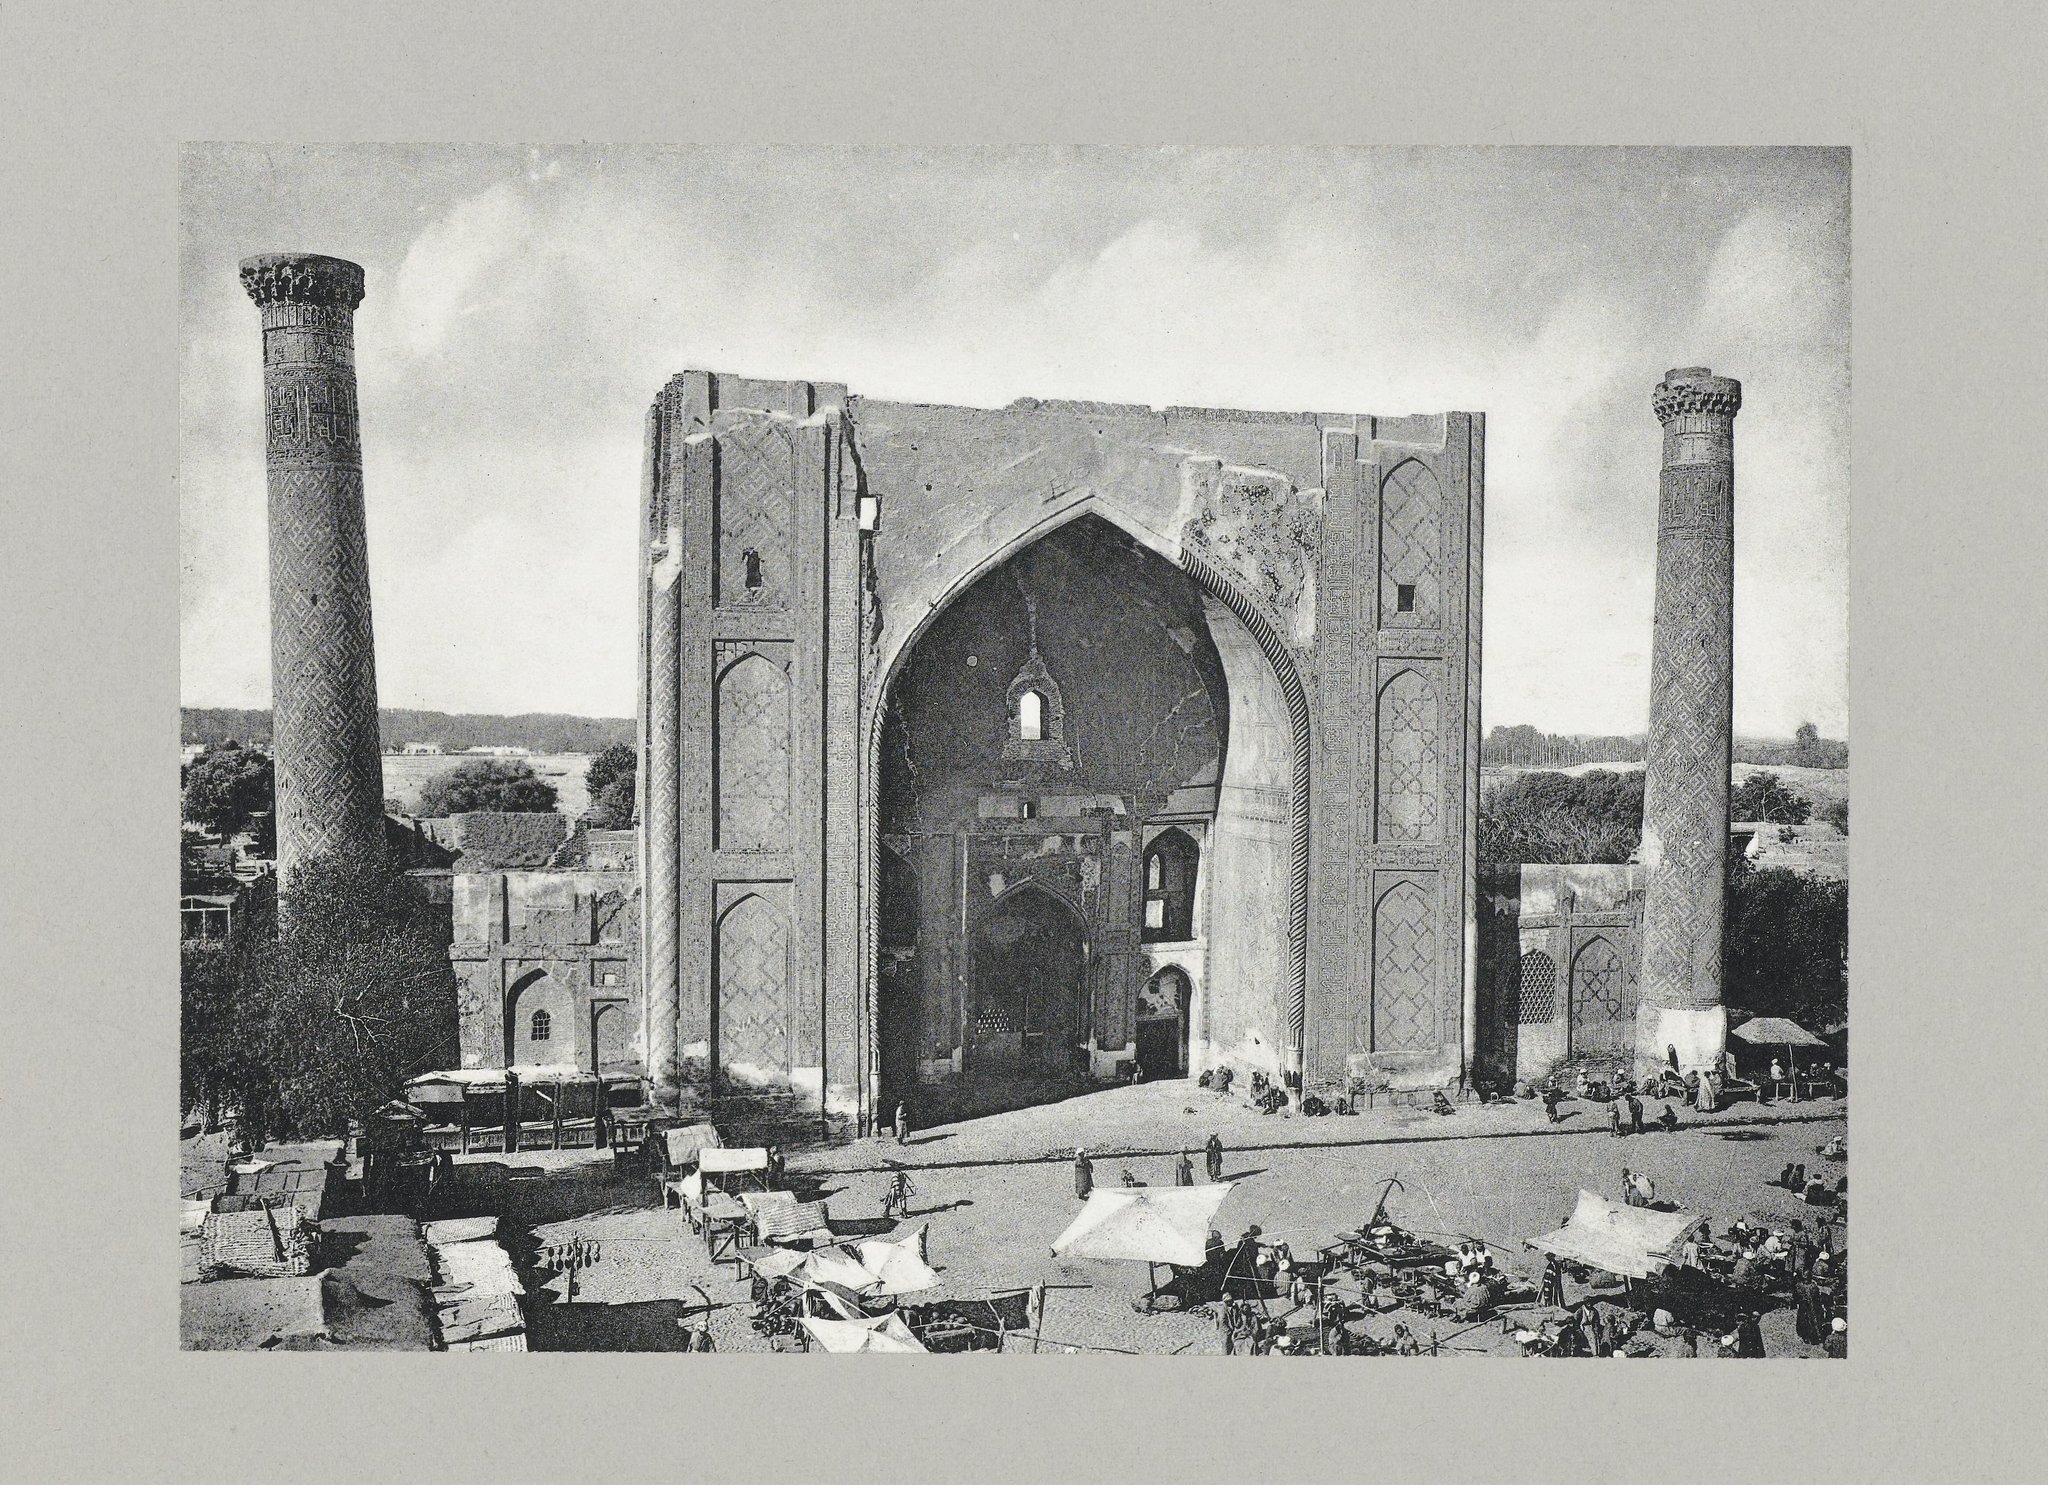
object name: photomechanical print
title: Moskee op de marktplaats te Samarkand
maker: Anonymous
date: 1895-1915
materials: cardboard, paper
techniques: photograph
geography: samarqand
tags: samarqand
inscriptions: annotation: ‘11. Moskee op de Marktplaats te Samarkand.’